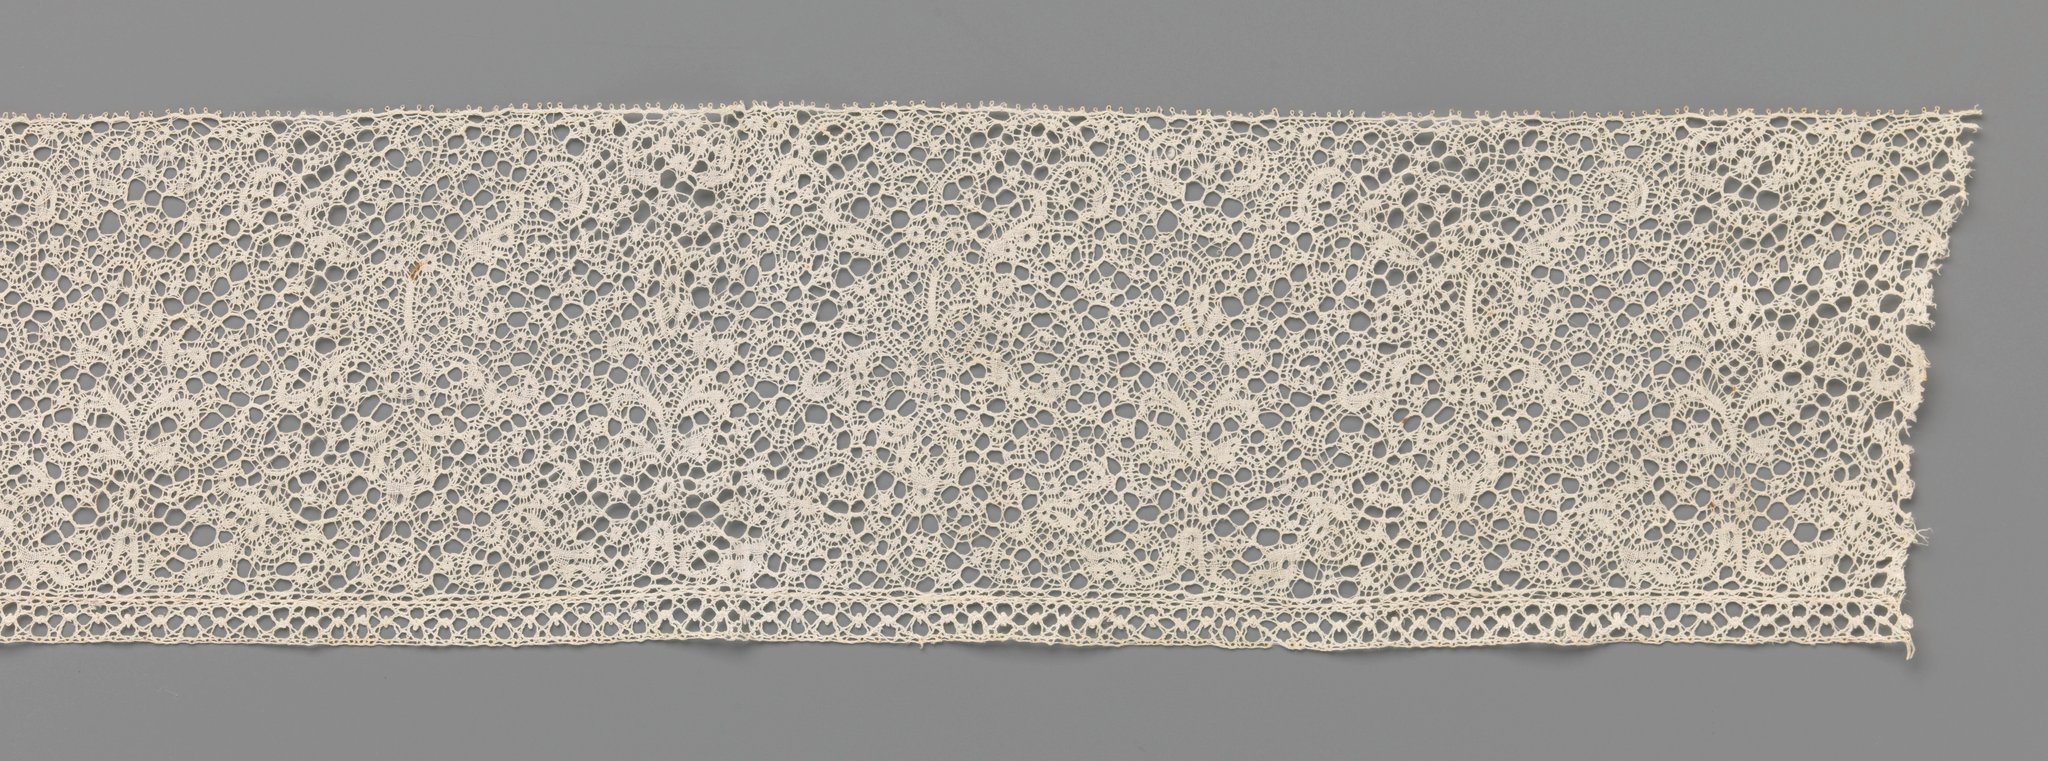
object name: strip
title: Strook kloskant met twee kandelabermotieven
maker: Anonymous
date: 1690-1699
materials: linen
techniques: lace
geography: southern netherlands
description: Strook naturelkleurige kloskant, Binche-kant. Het zich herhalende en ijle patroon bestaat uit een twee verschillende symmetrische kandelabermotieven. De smalste van de twee heeft een druppelvormig centrum, de bredere is vanuit vier punten rond het centrum voorzien van voluutjes, en vormen een x. De kandelabermotieven staan afwisselend omgekeerd. De motieven zijn met elkaar verbonden door een onregelmatige siergrond, een sneeuwvlokkengrond. De bovenzijde is afgewerkt met een apart geklost bandje. De onderzijde is recht afgewerkt en voorzien van picots.